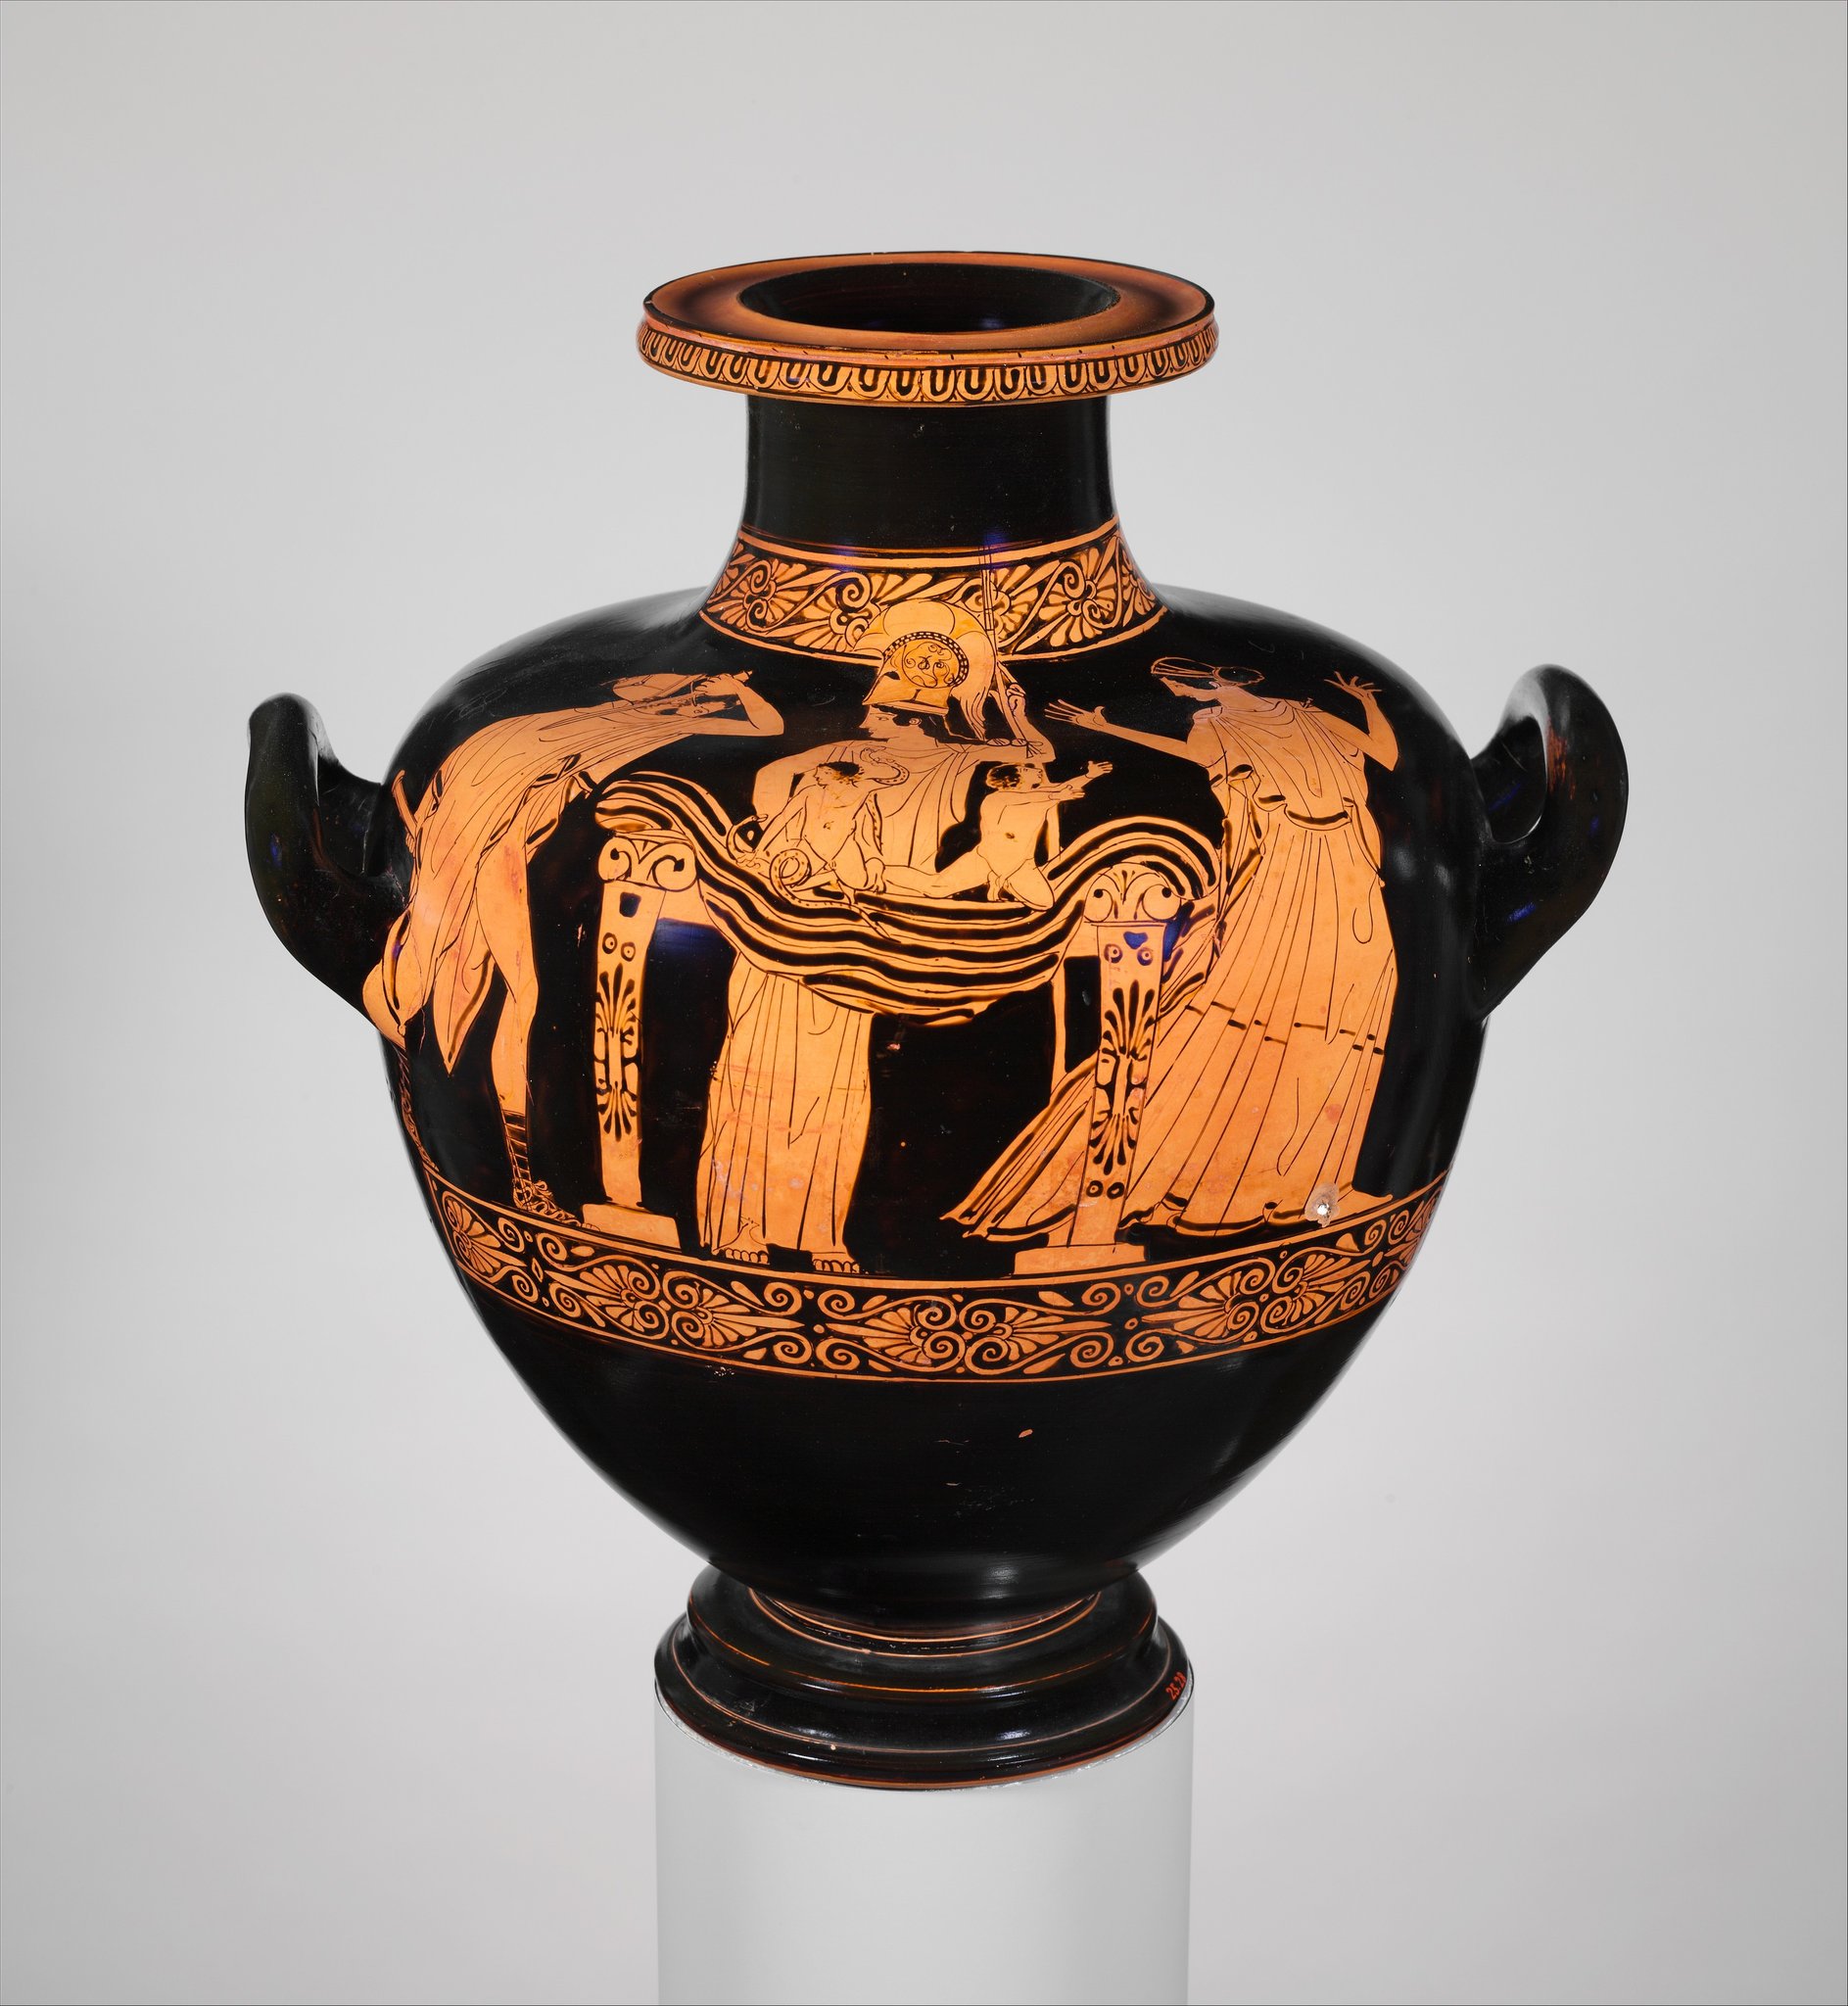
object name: hydria, kalpis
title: Terracotta hydria: kalpis (water jar)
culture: greek, attic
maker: nausicaä painter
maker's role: artist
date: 460-450 BCE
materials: terracotta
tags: infants,athena,serpents,herakles